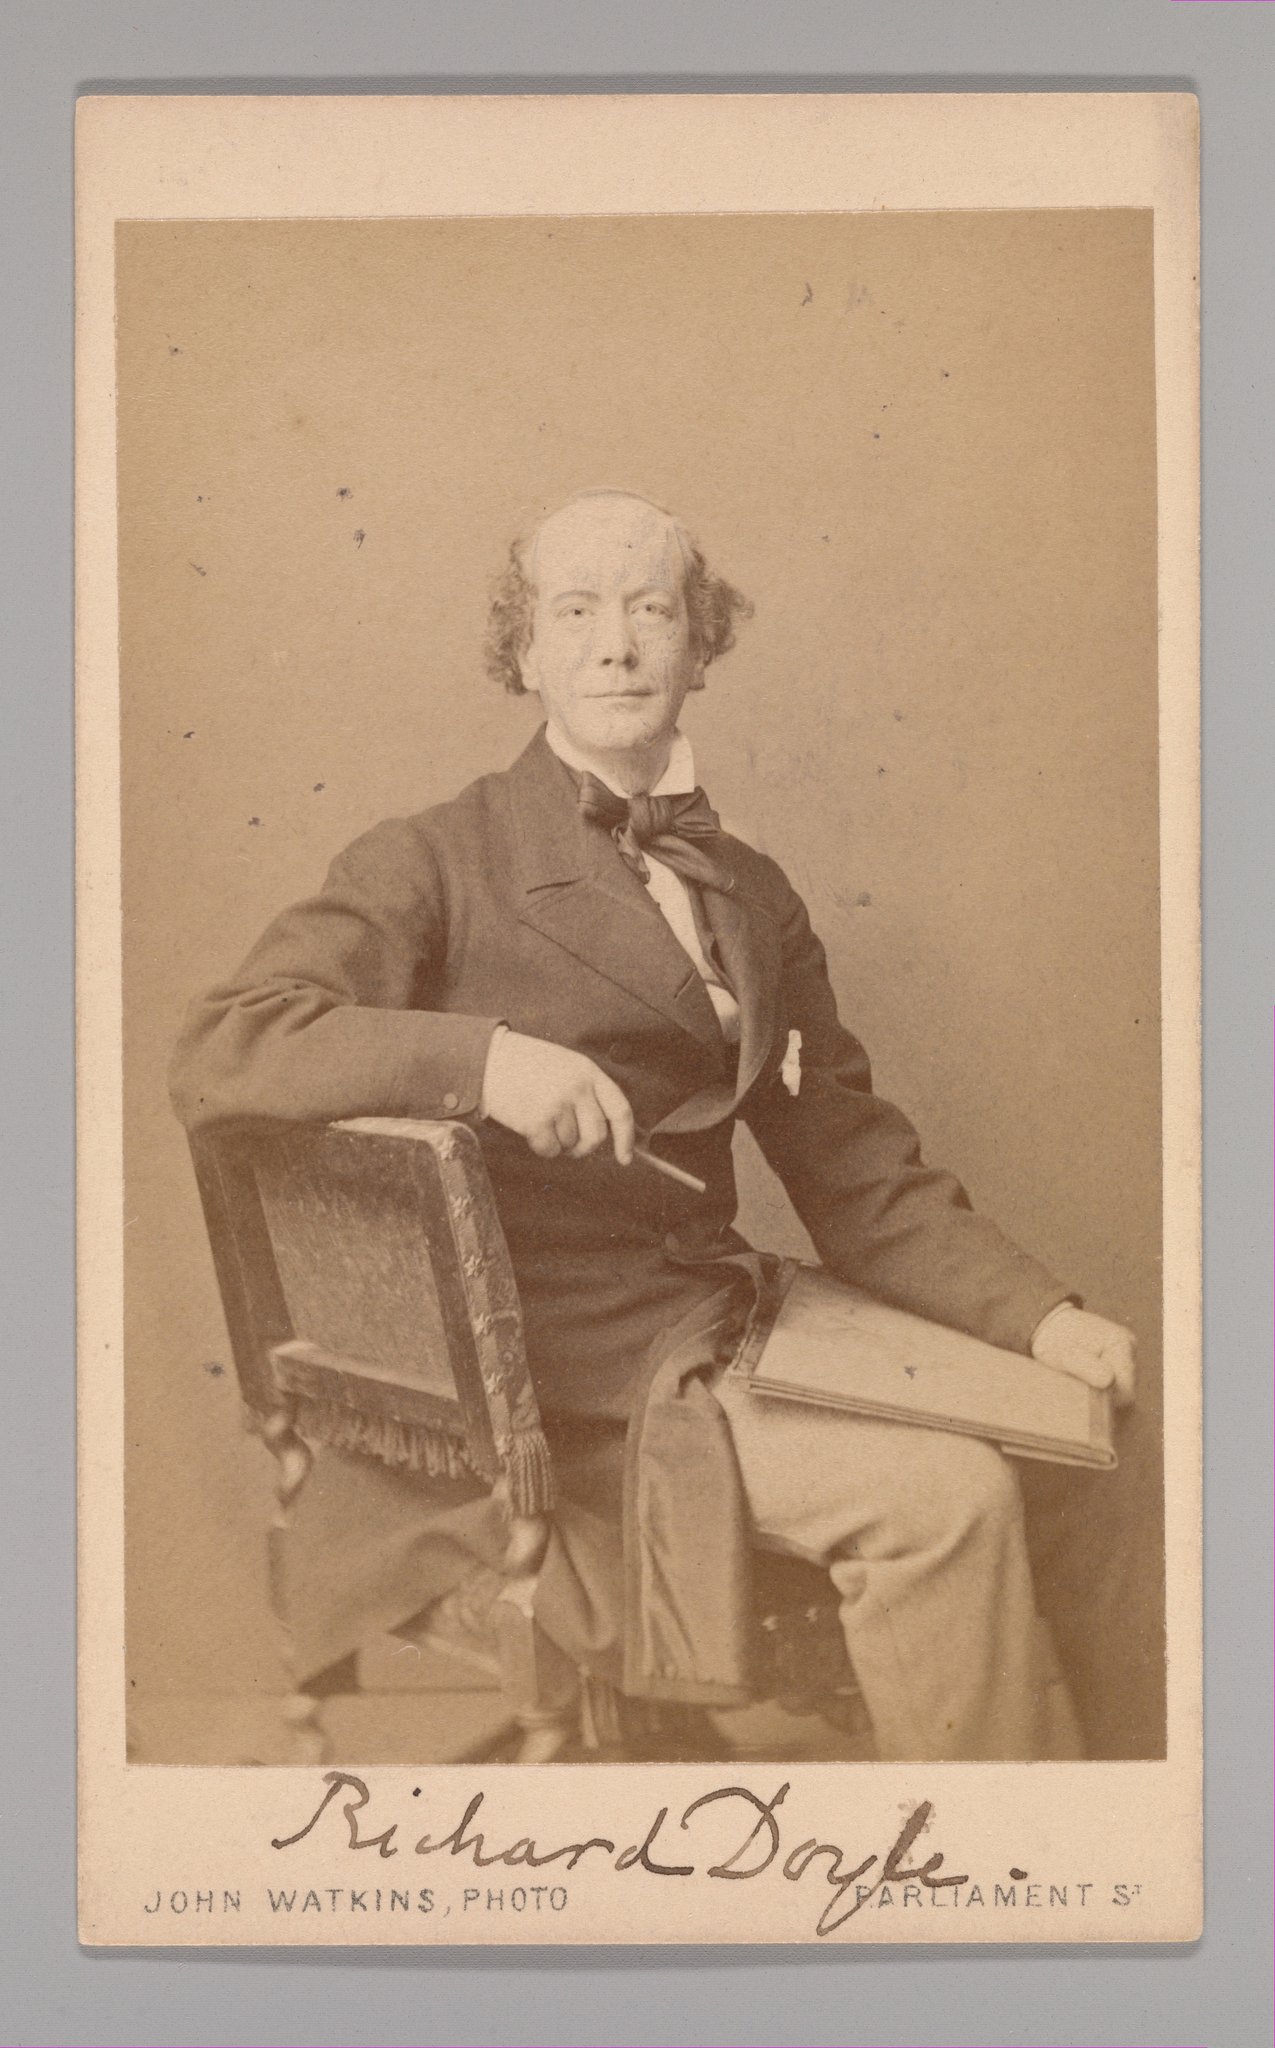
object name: carte de visite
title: [Richard Doyle]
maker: john and charles watkins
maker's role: photography studio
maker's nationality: british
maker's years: 1840-1875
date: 1860-1869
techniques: albumen silver print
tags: men,portraits